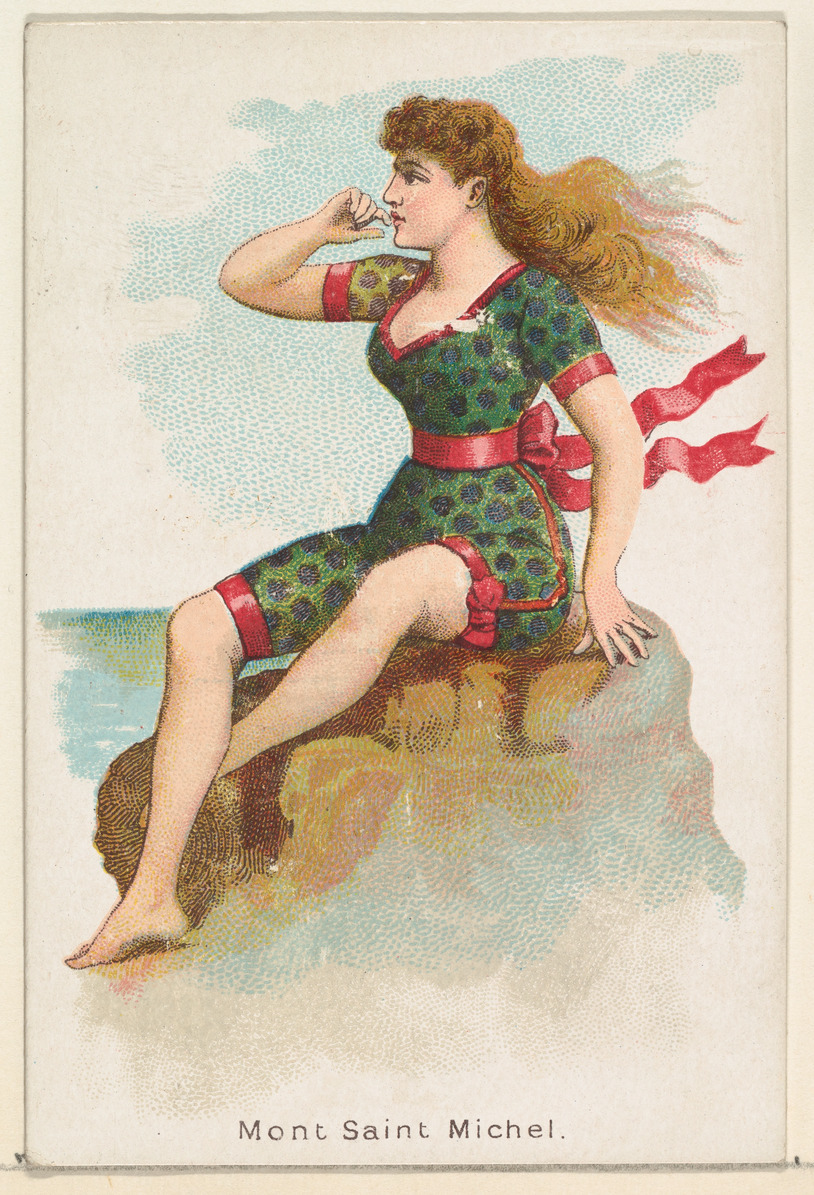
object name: print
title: Mont Saint Michel, from the Beautiful Bathers series (N192) issued by Wm. S. Kimball & Co.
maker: william s. kimball & company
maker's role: publisher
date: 1889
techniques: color lithograph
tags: profiles,women